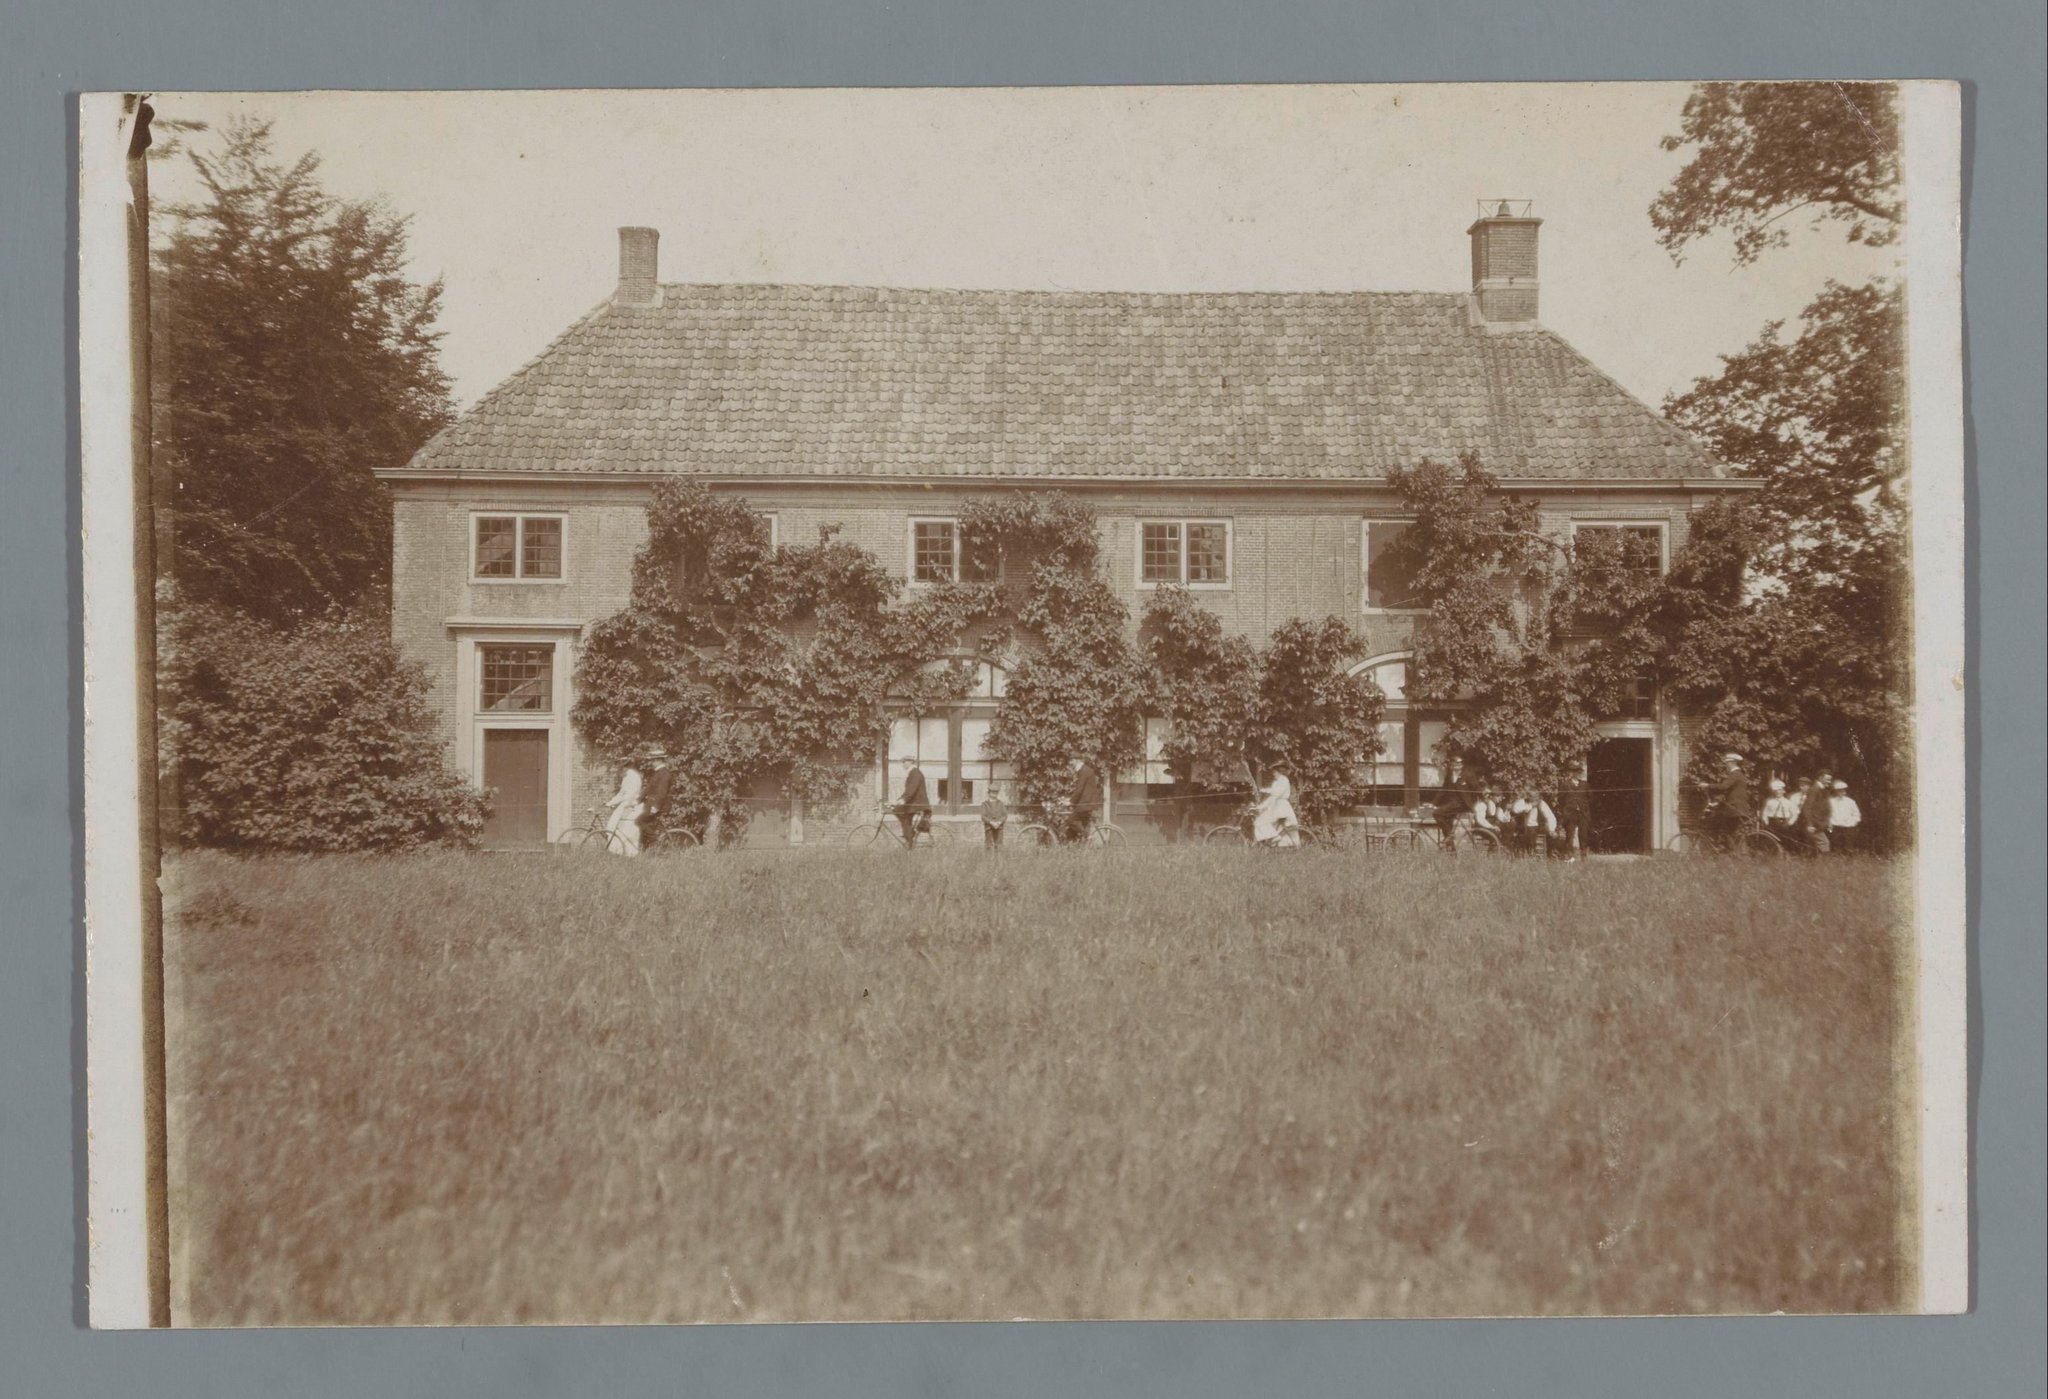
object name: photograph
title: Fietsend gezelschap voor een landhuis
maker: Anonymous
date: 1895-1910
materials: photographic support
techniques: daylight paper print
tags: riding, cycling (recreation), rural housing, e.g. country-house, villa, cottage, façade (of house or building)